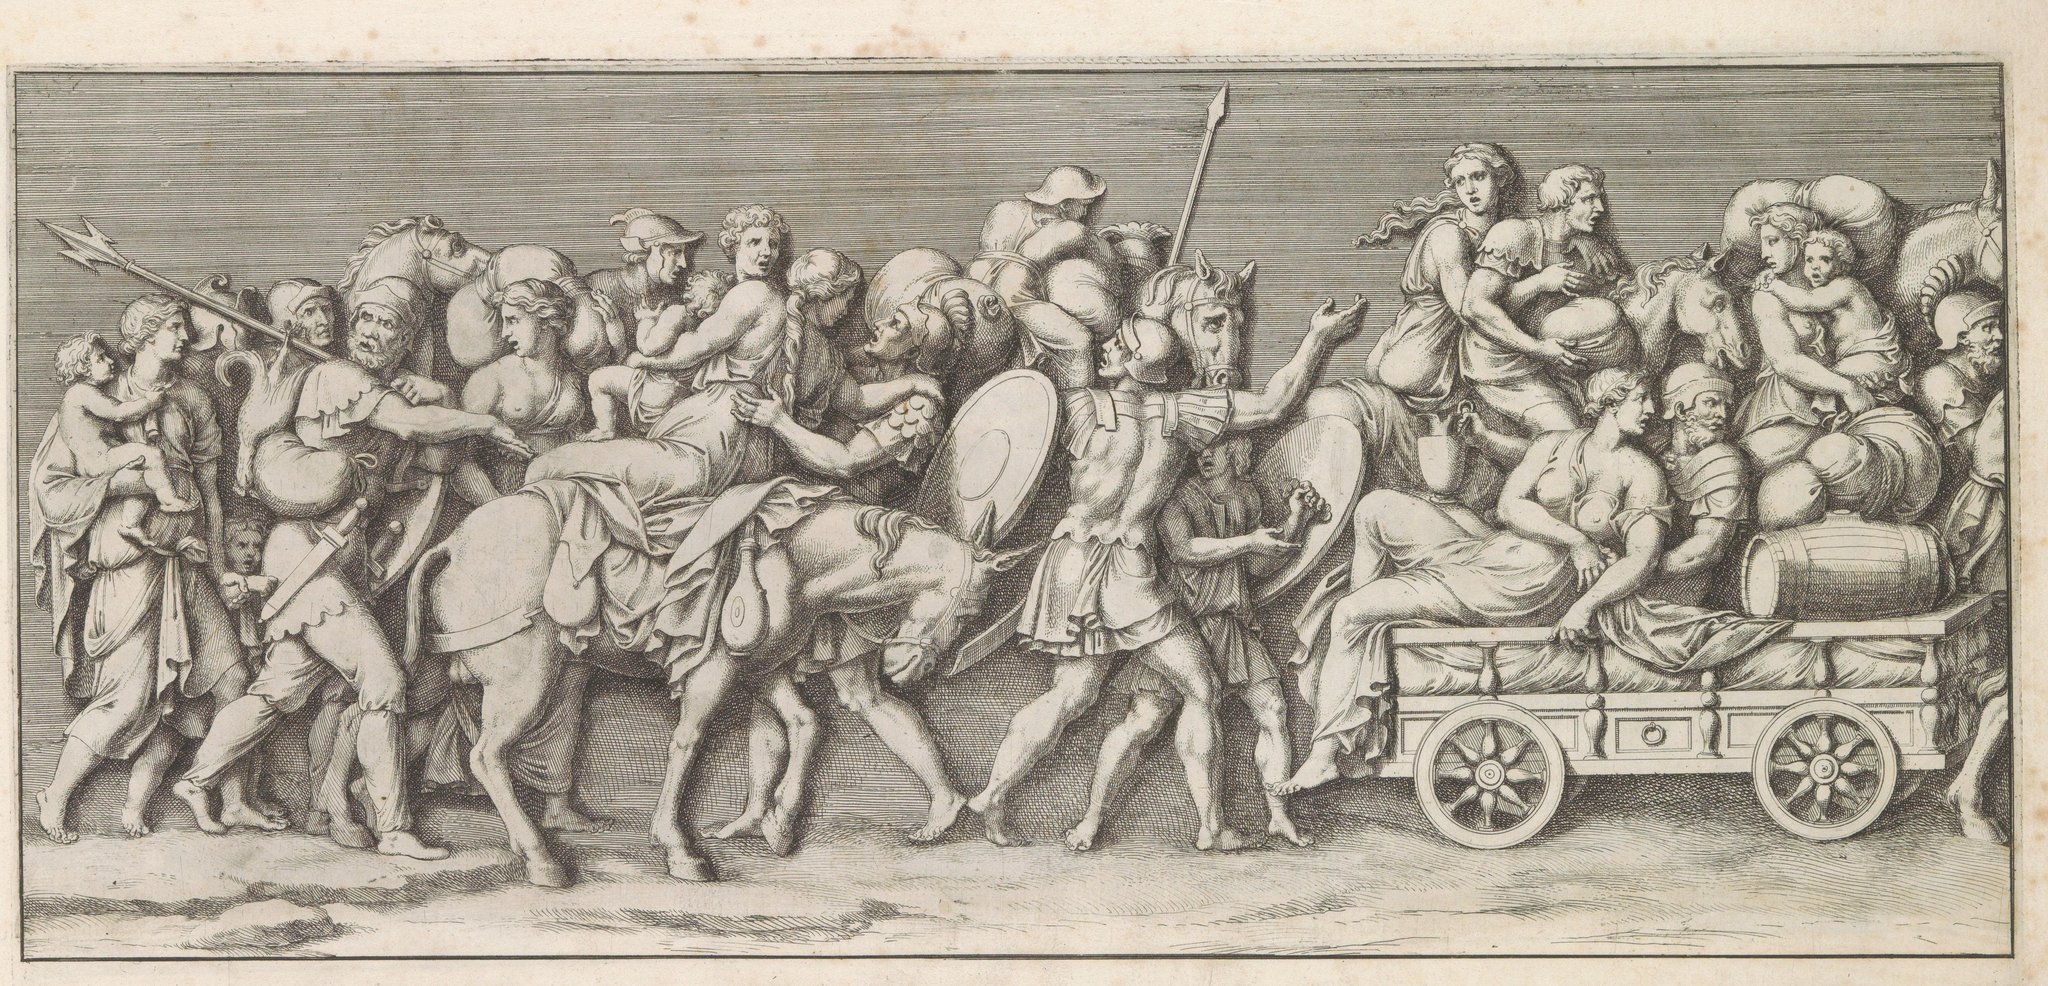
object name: print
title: Sigismundi Augusti Mantuam adeuntis profectio ac triumphus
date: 1680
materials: paper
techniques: etching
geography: rome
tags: triumphal entry and public reception, pageant, 'entrée solennelle', 'joyeuse entrée', military parade, pageant, the soldier; the soldier's life, mother and child(ren), woman and child(ren) (family group), (military) equipment and supply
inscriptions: number: ‘1’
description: Prent maakt deel uit van een reeks van 25 prenten (+ titelprent) naar het stucwerk door Giulio Romano en Francesco Primaticcio in de Sala degli Stucchi in Palazzo del Te te Mantua.